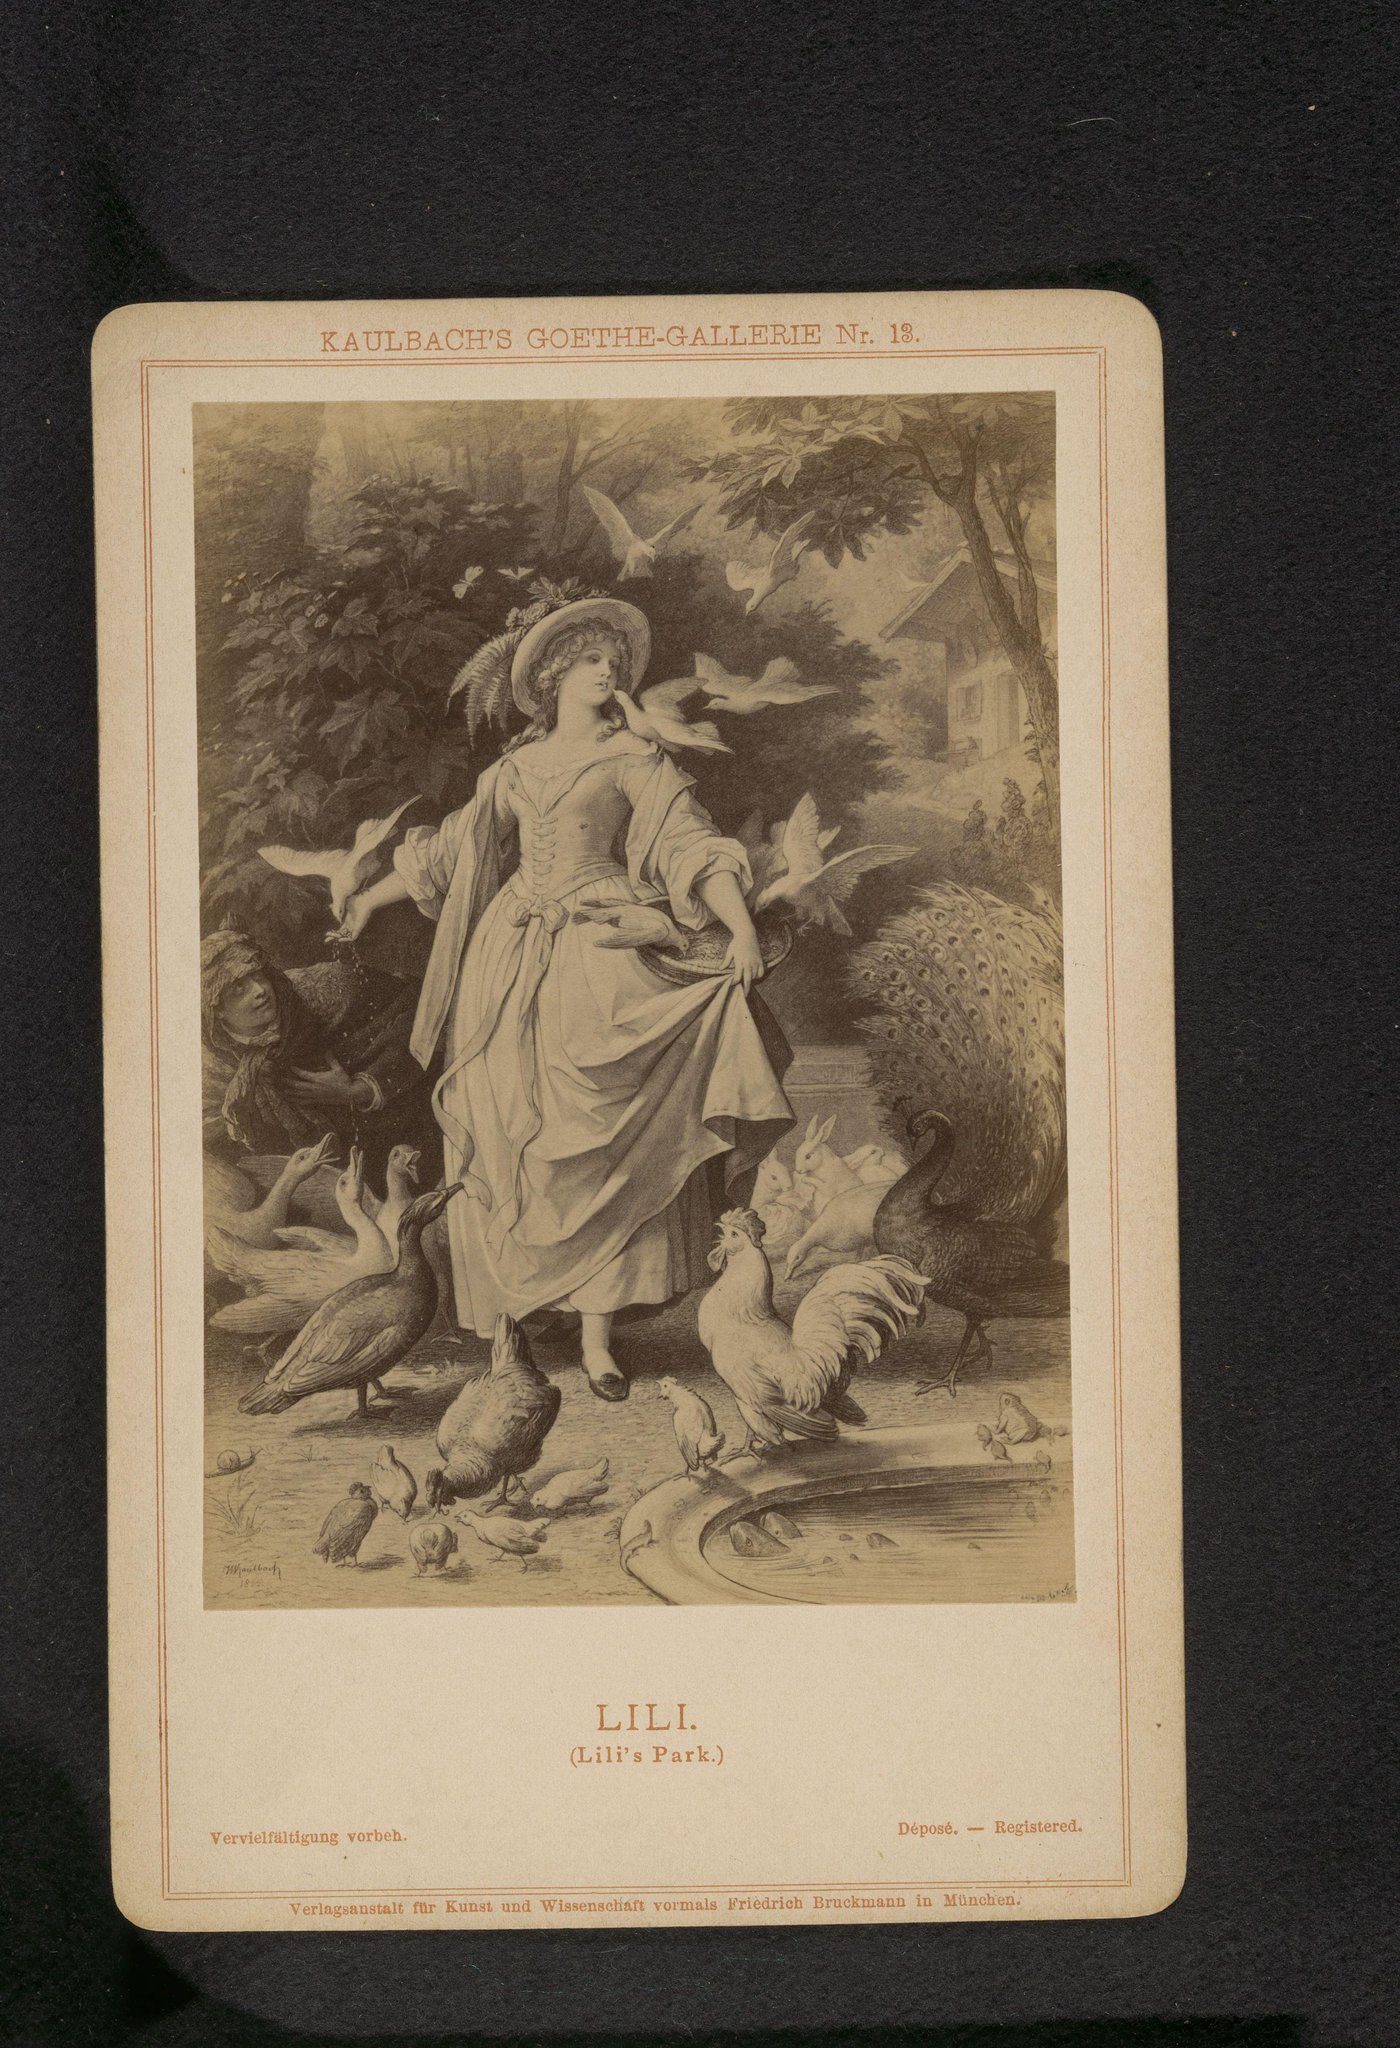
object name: photograph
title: Lili (Lili's park)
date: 1880-1885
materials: photographic support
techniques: albumen print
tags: birds, adult man, literary characters and objects, painting, drawing and the graphic arts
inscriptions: inscription: ‘Vervielfältigung vorbeh. Déposé - Registered./ Verlagsanstalt für Kunst und Wissenschaft vormals Friedrich Bruckmann in München.’, annotation: ‘24.12.94’, inscription: ‘Kaulbach's Goethe-Gallerie Nr. 13’, name: ‘Friedrich Bruckmann's Verlag/ München’